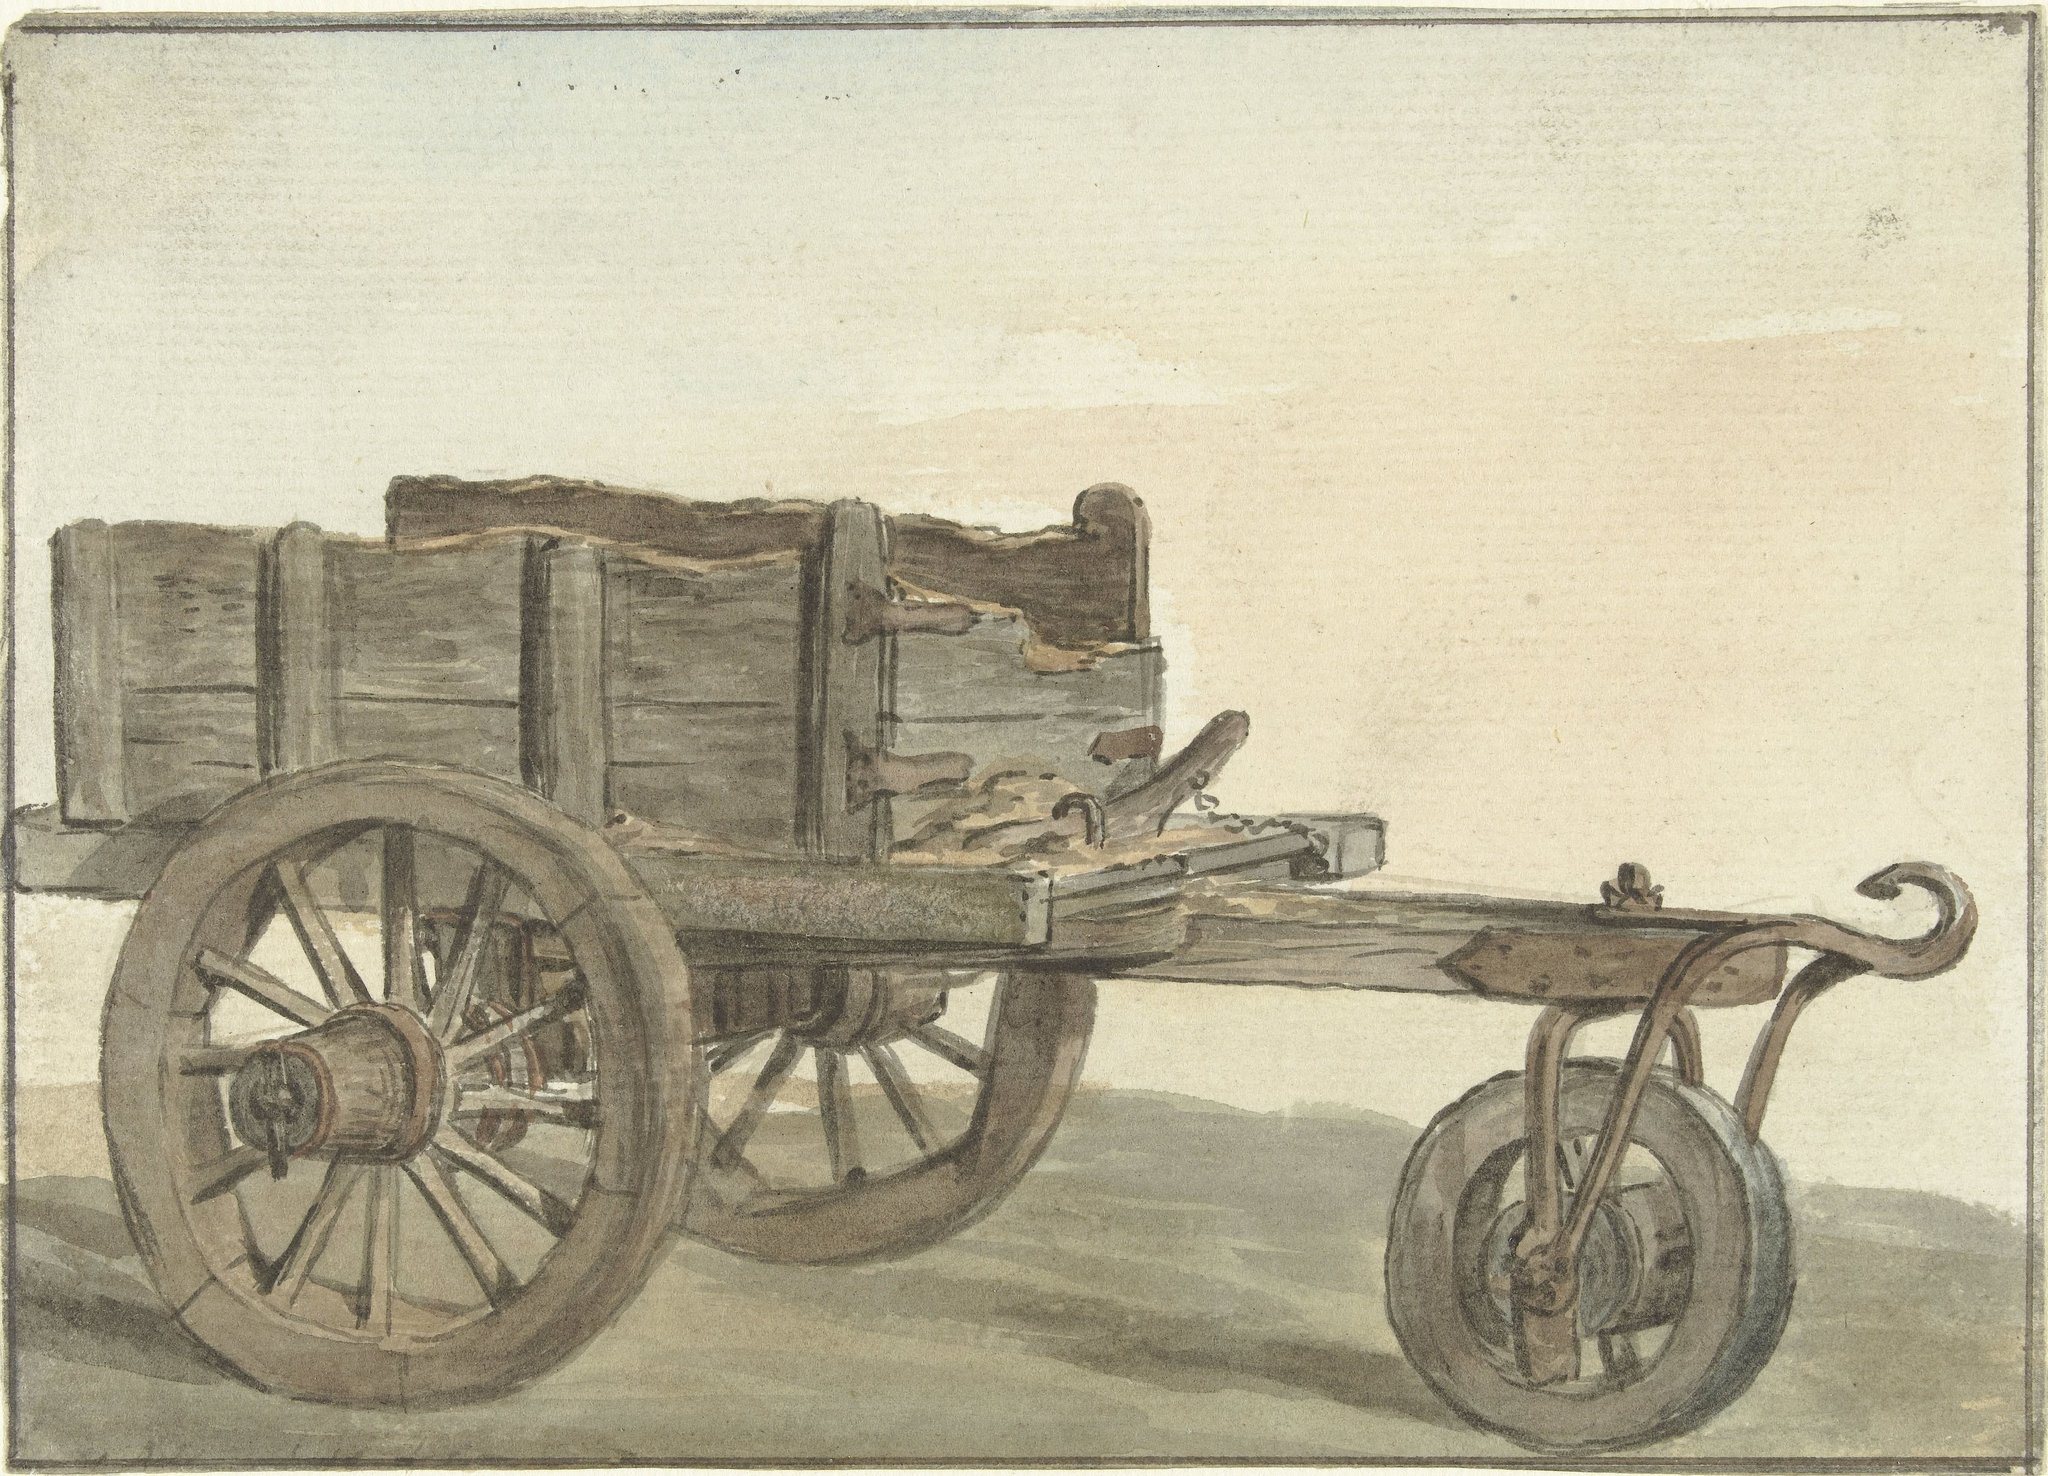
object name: watercolor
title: Boerenkar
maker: simon andreas krausz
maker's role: draughtsman, print maker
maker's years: 1760-1825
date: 1770-1825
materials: ink, paper, watercolor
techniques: brush, pen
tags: (farm) wagon, freight wagon, cart